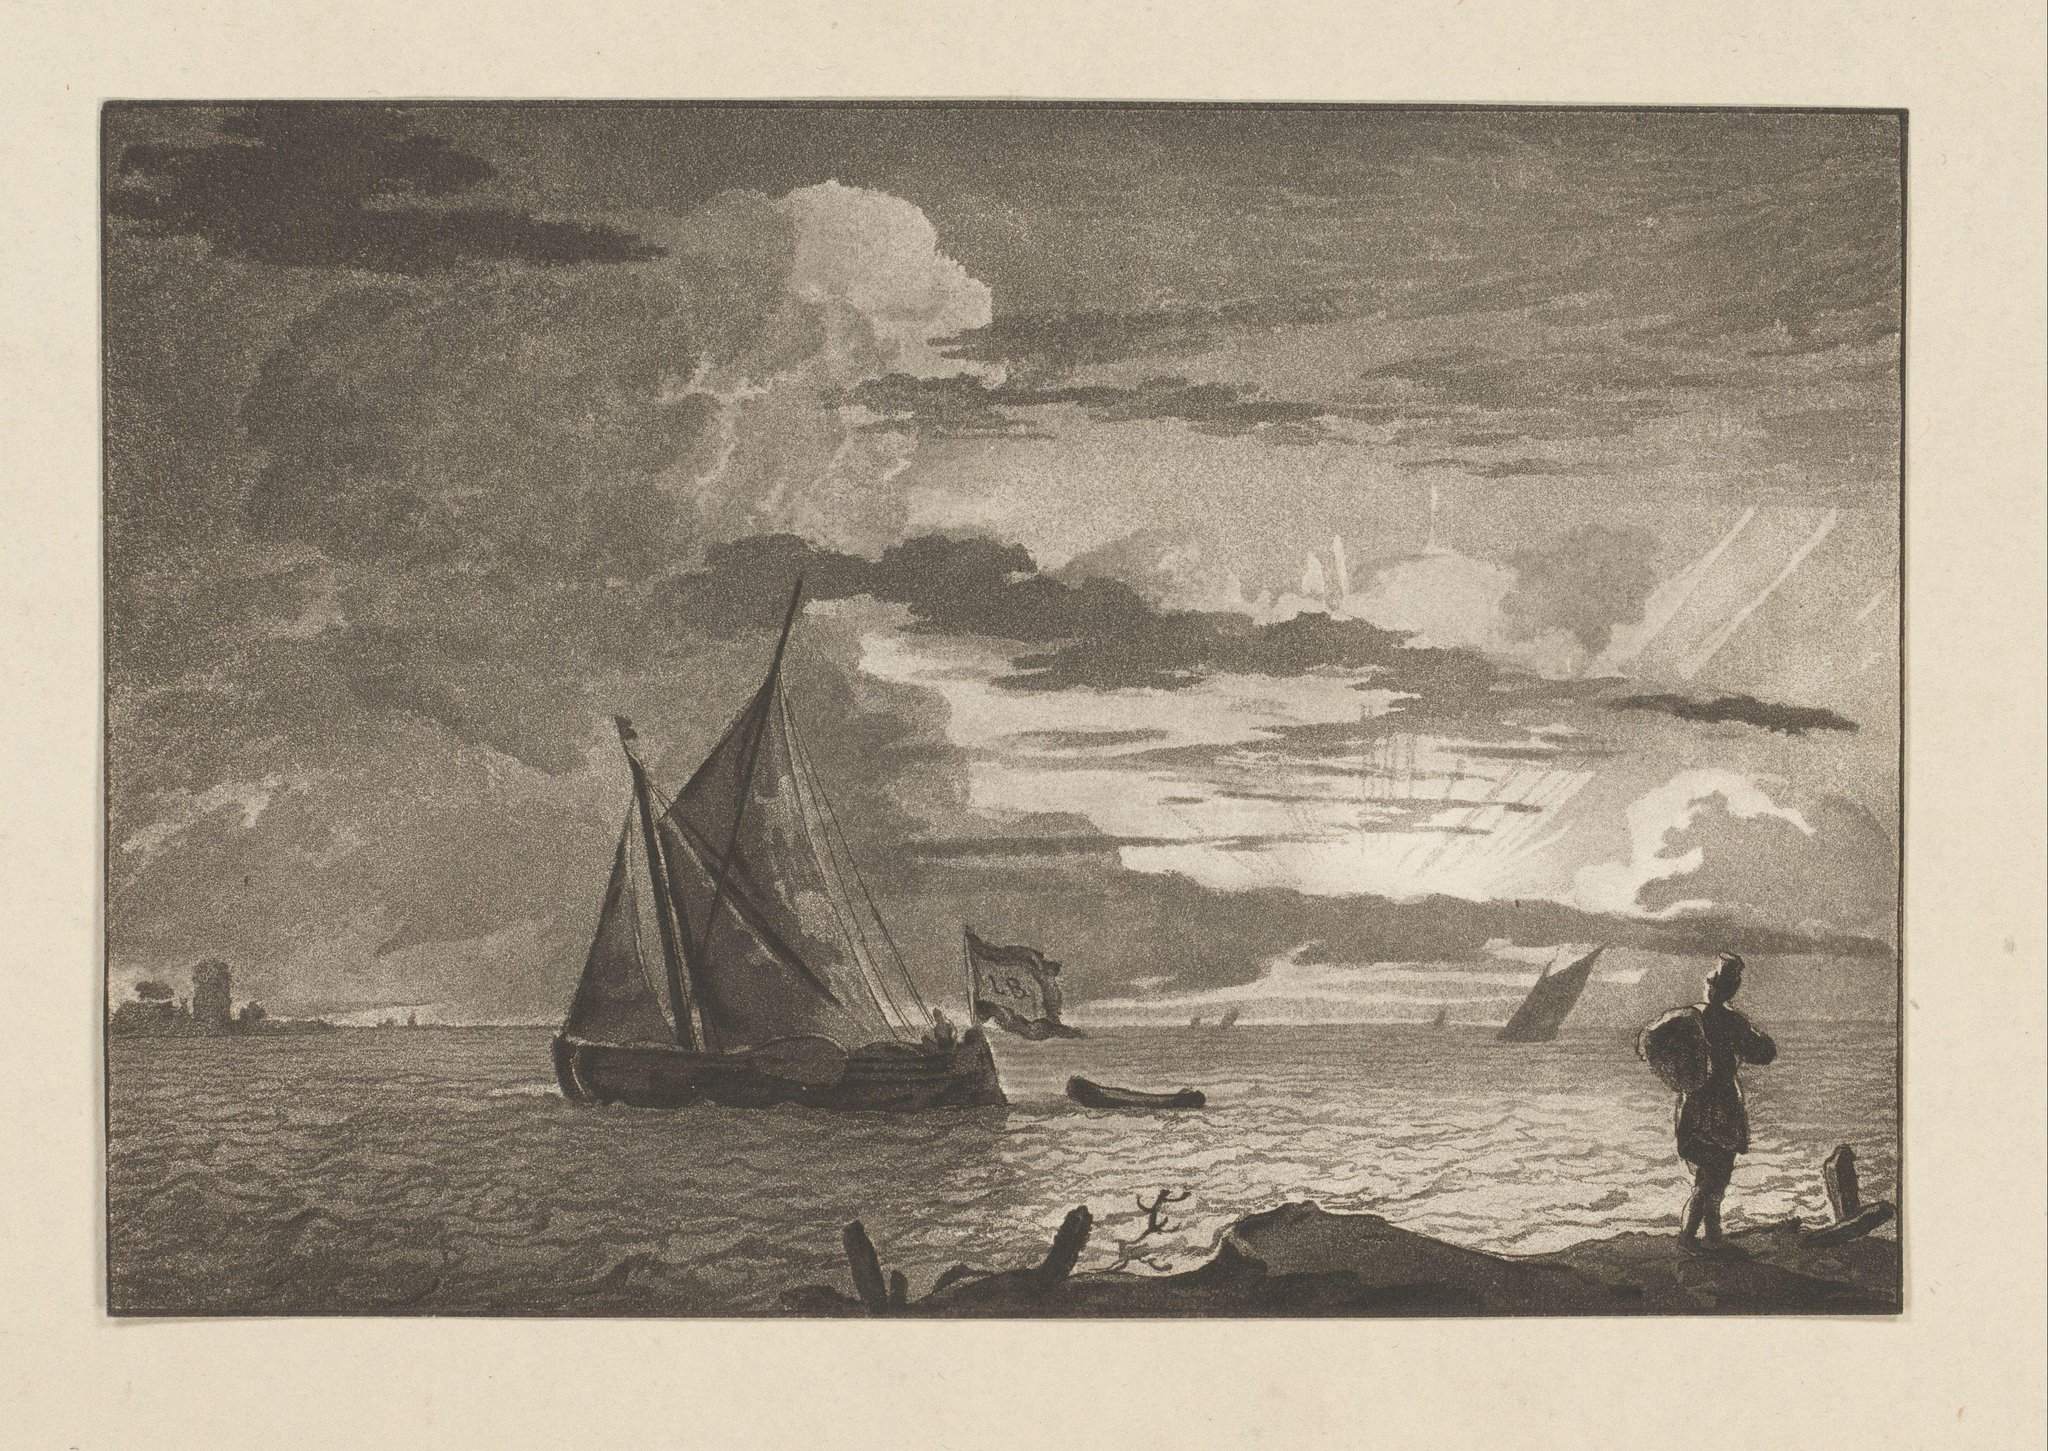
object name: print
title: Man met zak op de schouder bij zonsopgang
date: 1779-1781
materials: paper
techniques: transfer, print drawing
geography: amsterdam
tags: sailing-ship, sailing-boat, sunrise, carrying something on the head or on the shoulders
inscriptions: collector's mark: ‘RIJKS / MUSM’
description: Rechts op de voorgrond een man met een zak op de schouder kijkend naar de schepen en de zonsopgang. De prent ligt los in een album, zie blad 32.